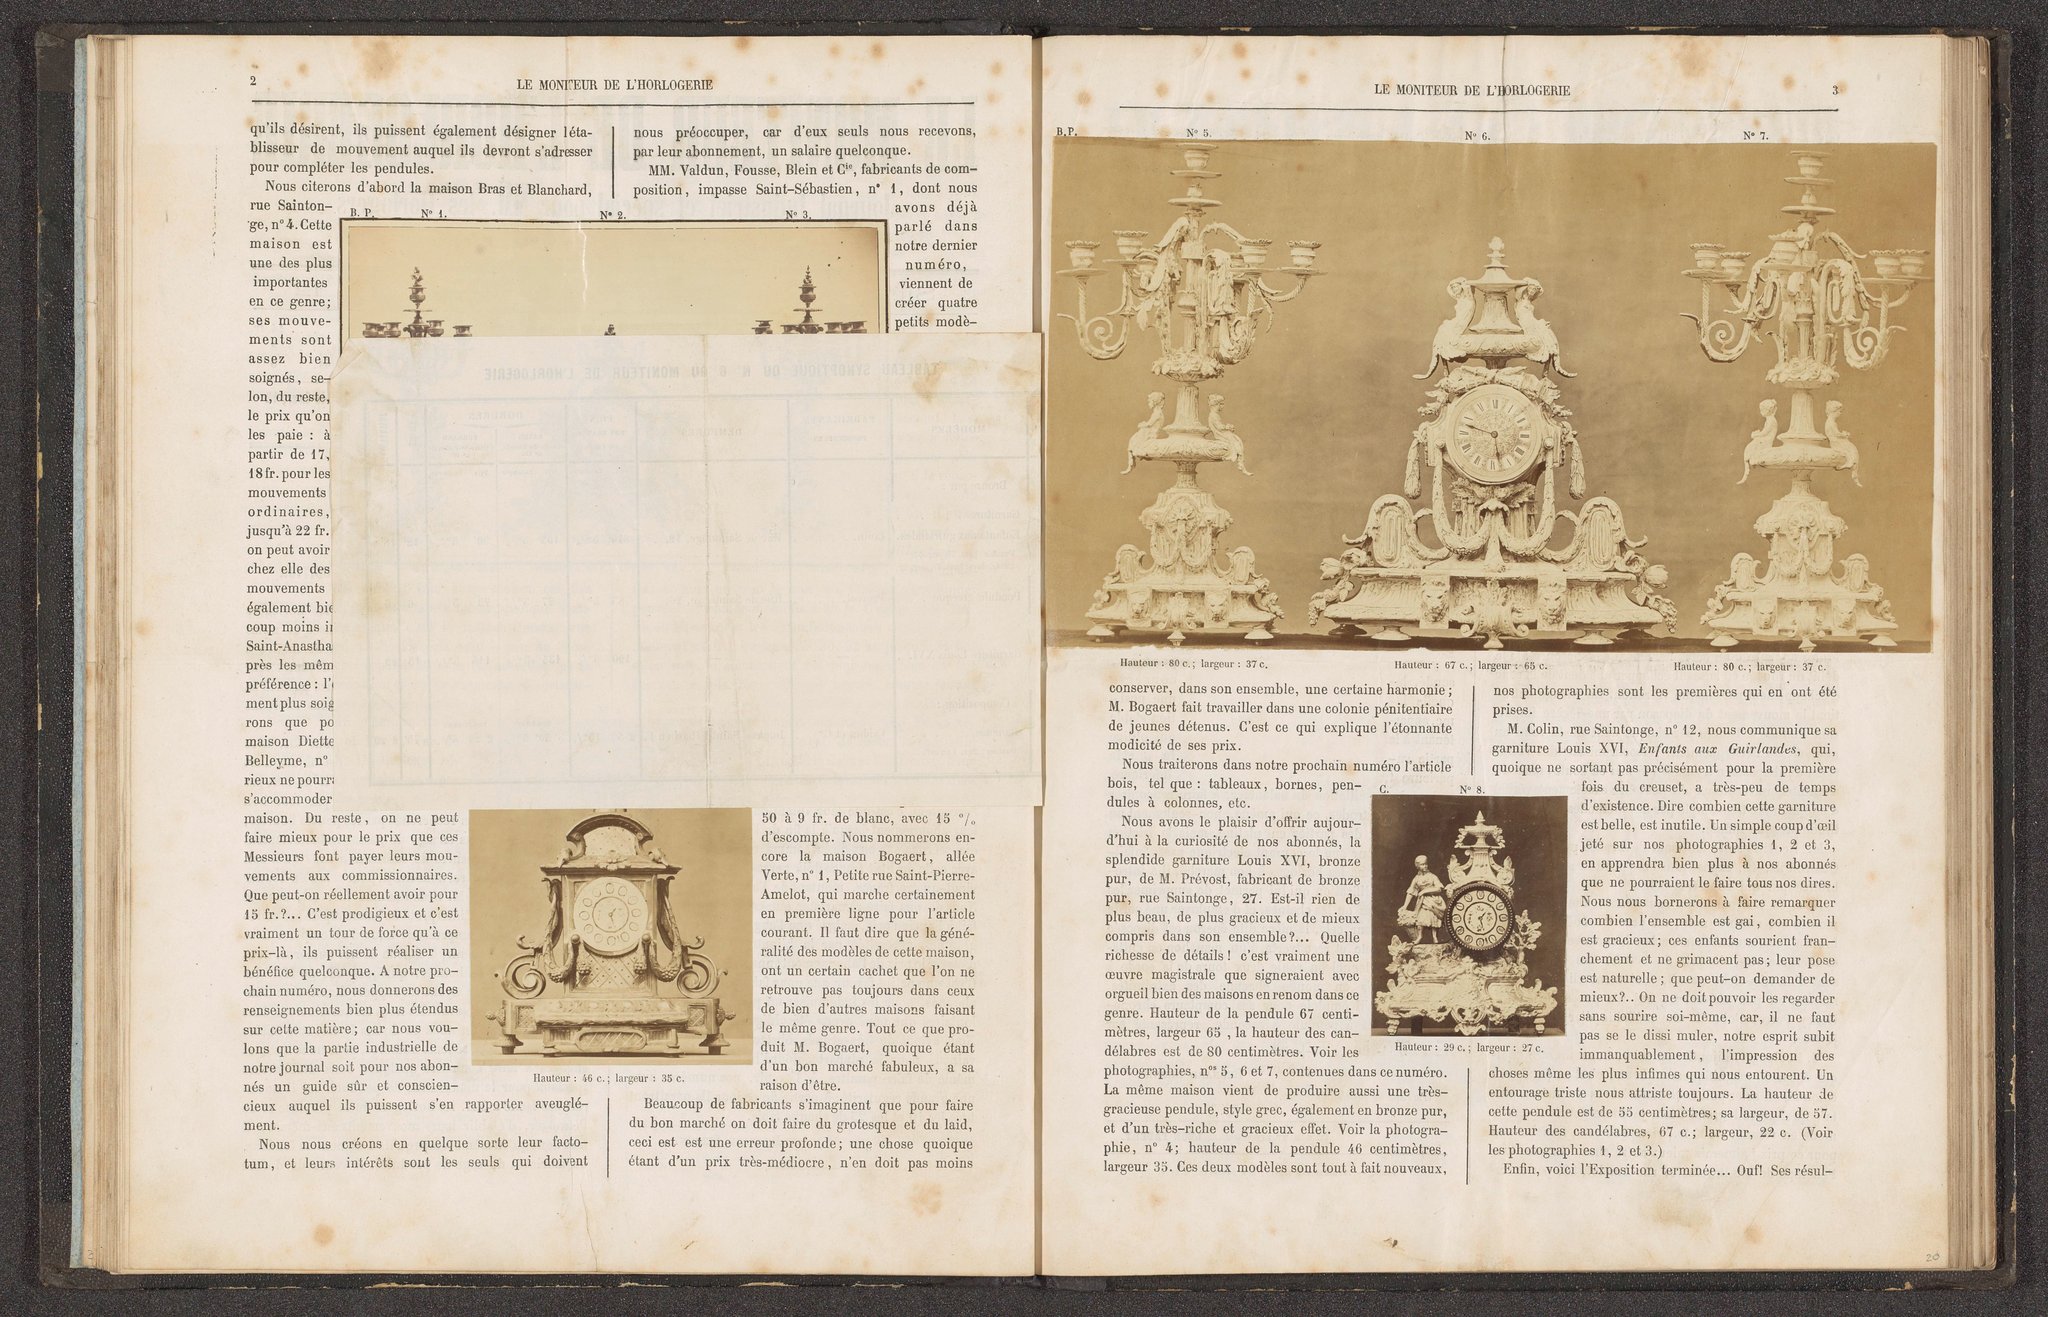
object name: photograph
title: Twee afbeeldingen van klokken en kandelaren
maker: Anonymous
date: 1857-1867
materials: photographic support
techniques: albumen print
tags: cut flowers; nosegay, bunch of flowers, clock, ornament ~ festoon, garland, candlestick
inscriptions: number: ‘B.P. No 5. No 6. No 7. No 8.’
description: Boven: klok en twee kandelaren gedecoreerd met guirlandes en meisjes door M. Prévost, onder: klok gedecoreerd met een meisje met een mand vol bloemen door Valdun et Cie.